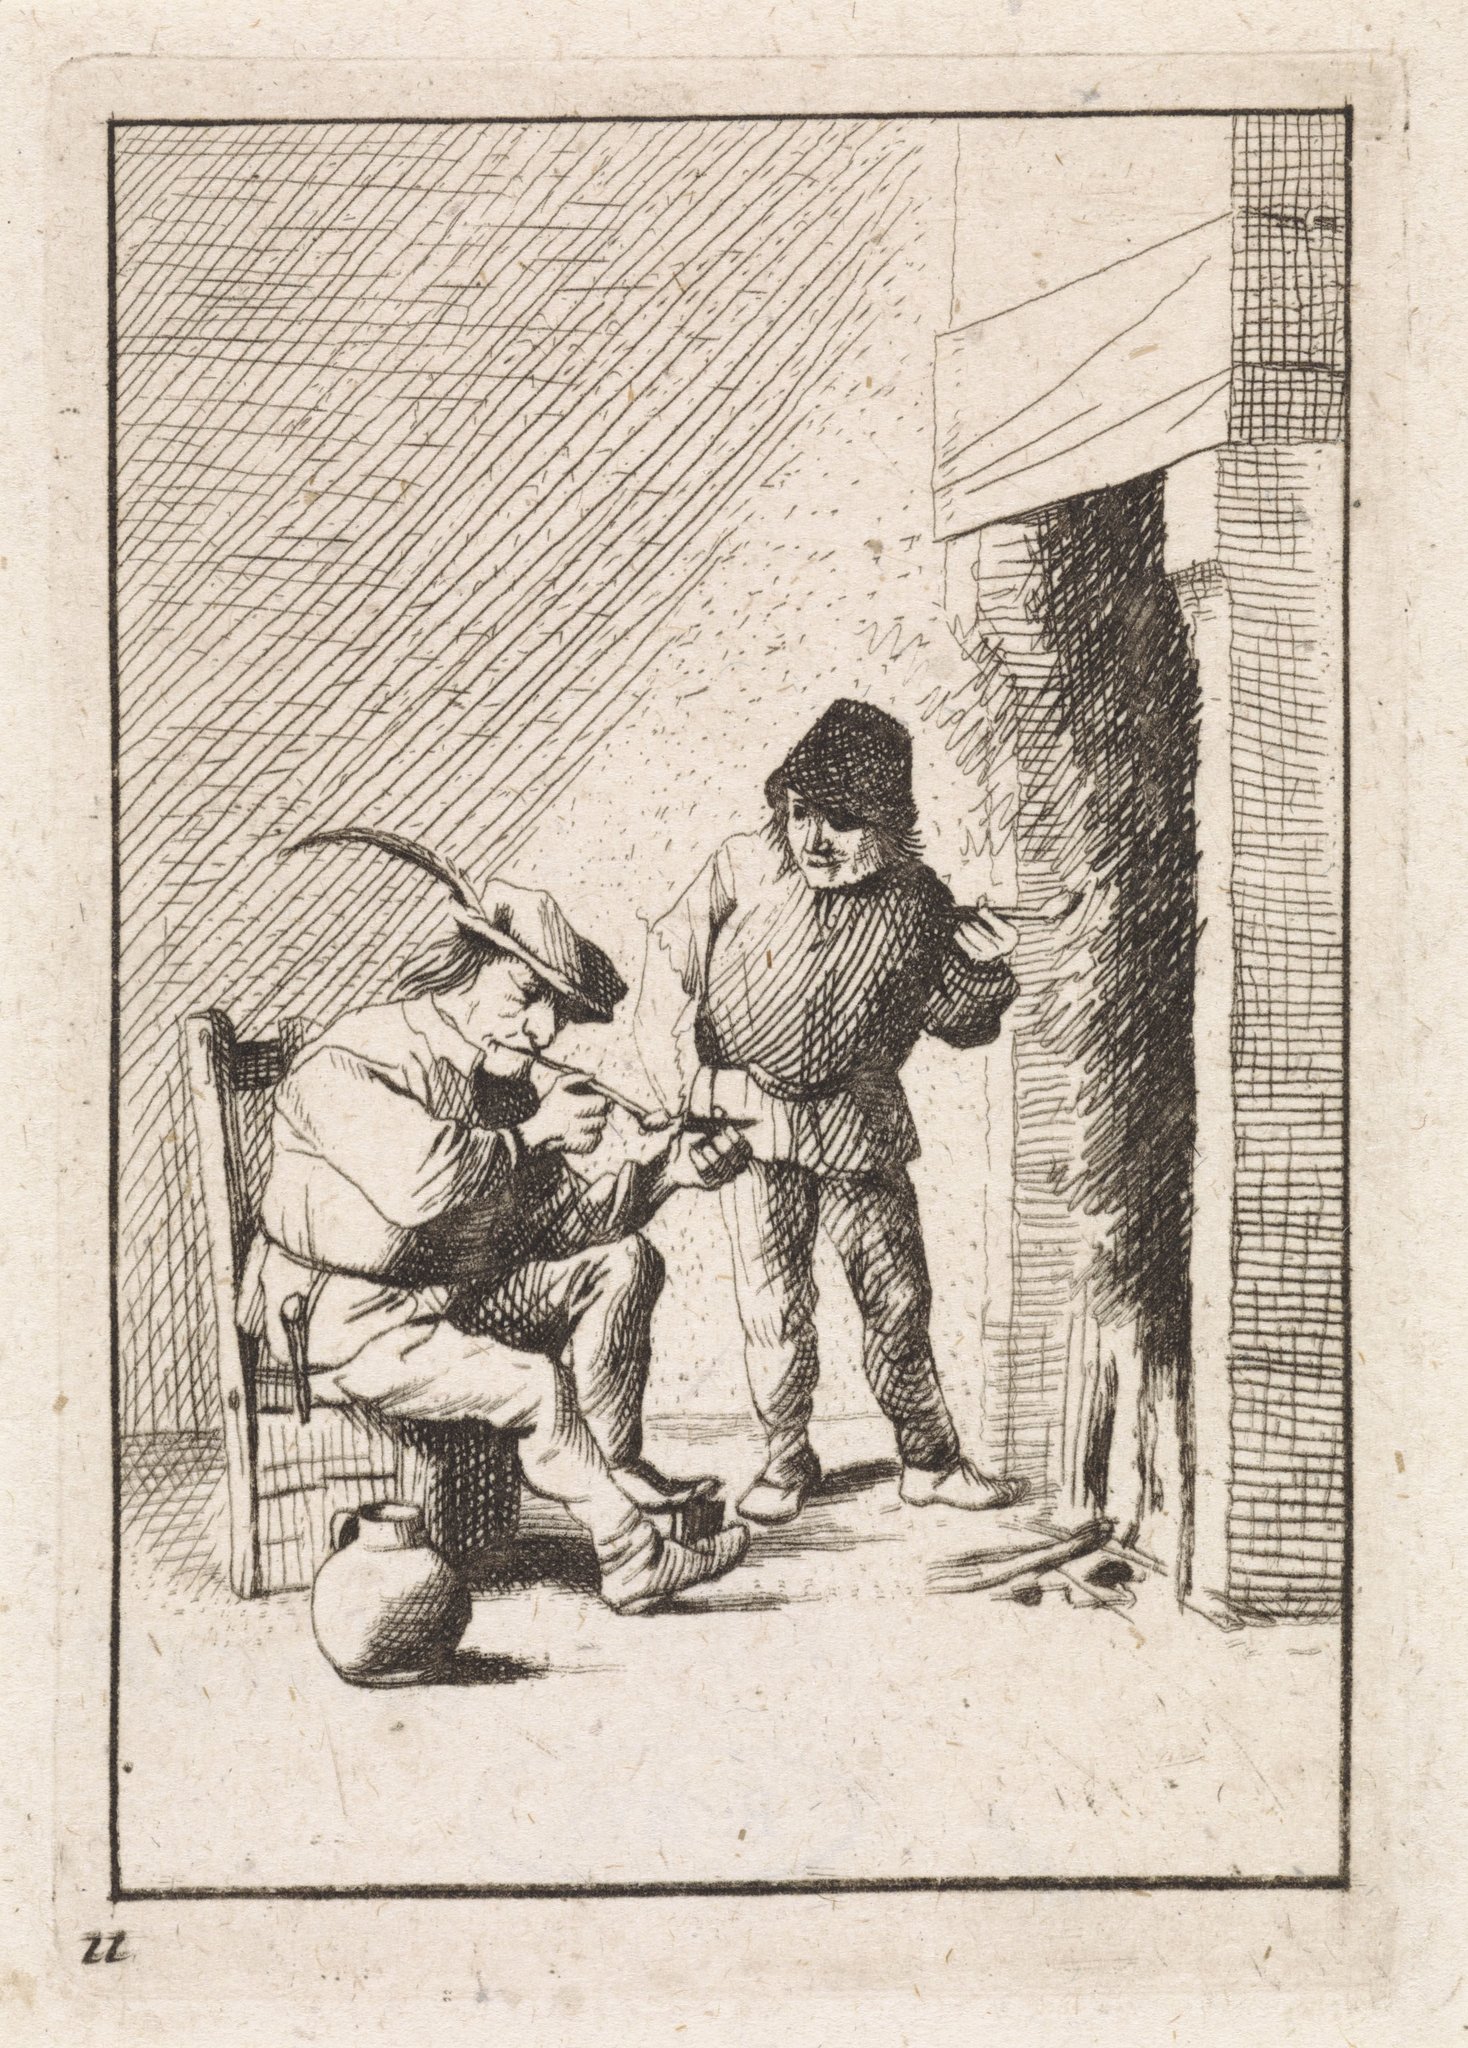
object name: print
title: Boeren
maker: Anonymous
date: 1626-1740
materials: paper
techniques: etching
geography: low countries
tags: pipe ~ tobacco, open hearth, fire-place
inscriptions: collector's mark: Lugt 2228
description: Een staande en een zittende boer roken allebei pijp bij de haard. Links een kruik.